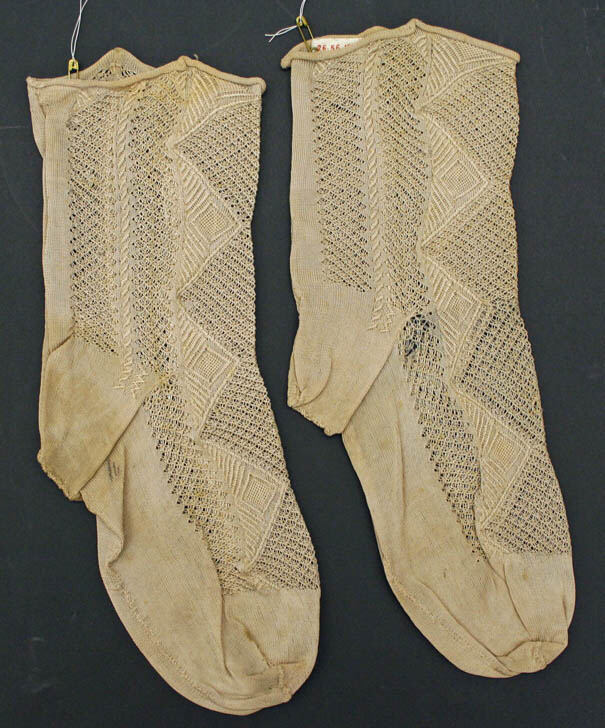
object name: sock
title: Socks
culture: italian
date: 1801-1833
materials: silk